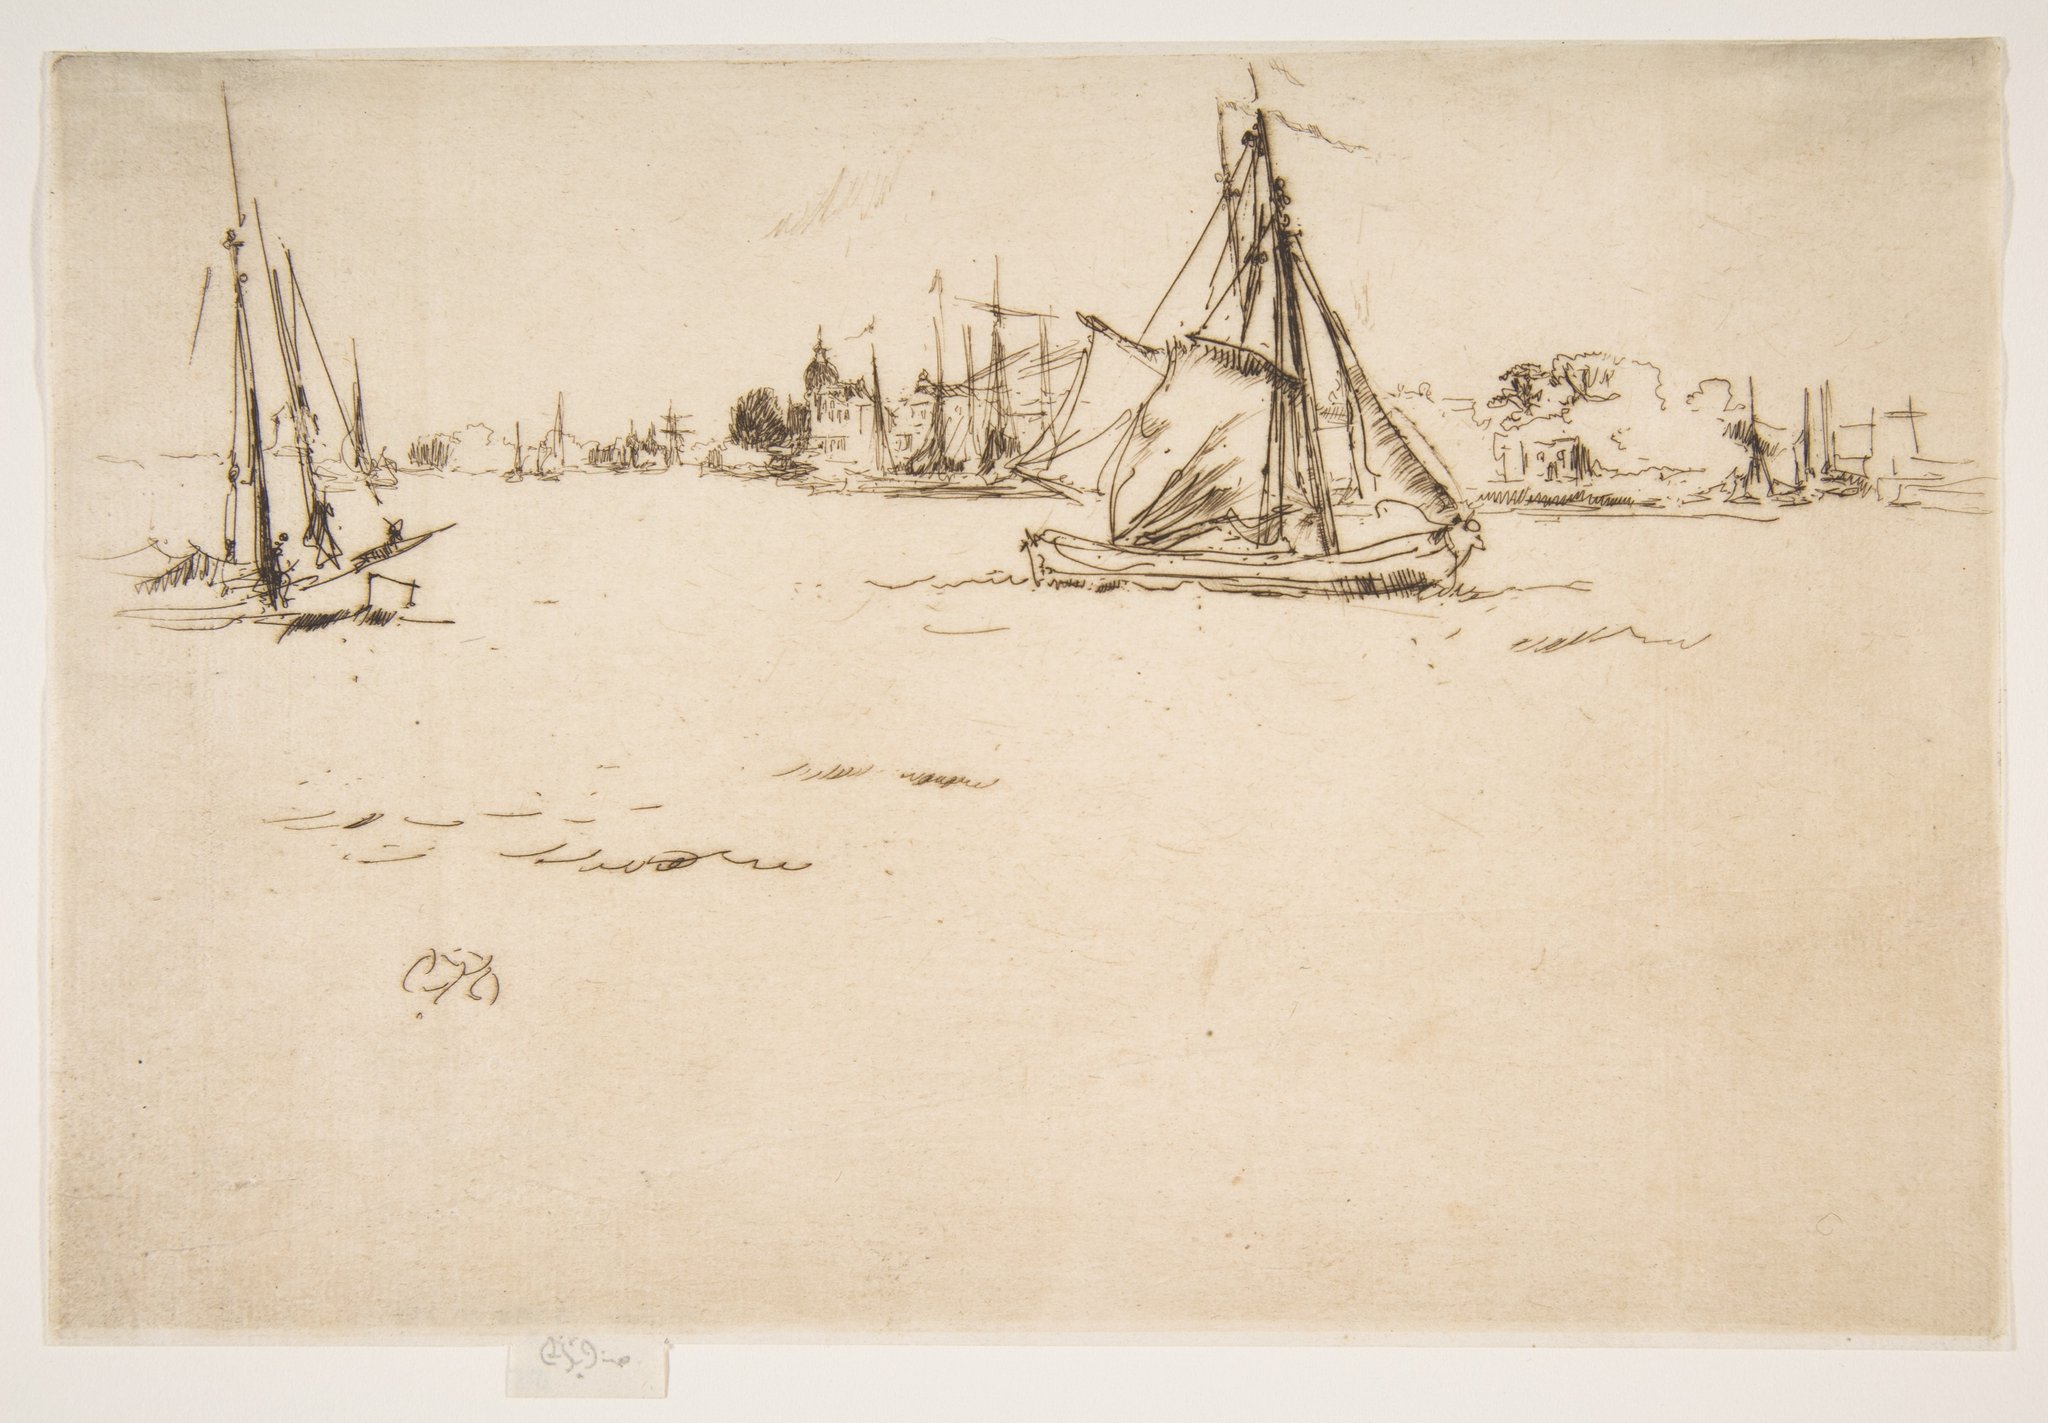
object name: print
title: Dordrecht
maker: james mcneill whistler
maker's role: artist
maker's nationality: american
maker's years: 1834-1903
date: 1886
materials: ink, paper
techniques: drypoint, etching, printing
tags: boats